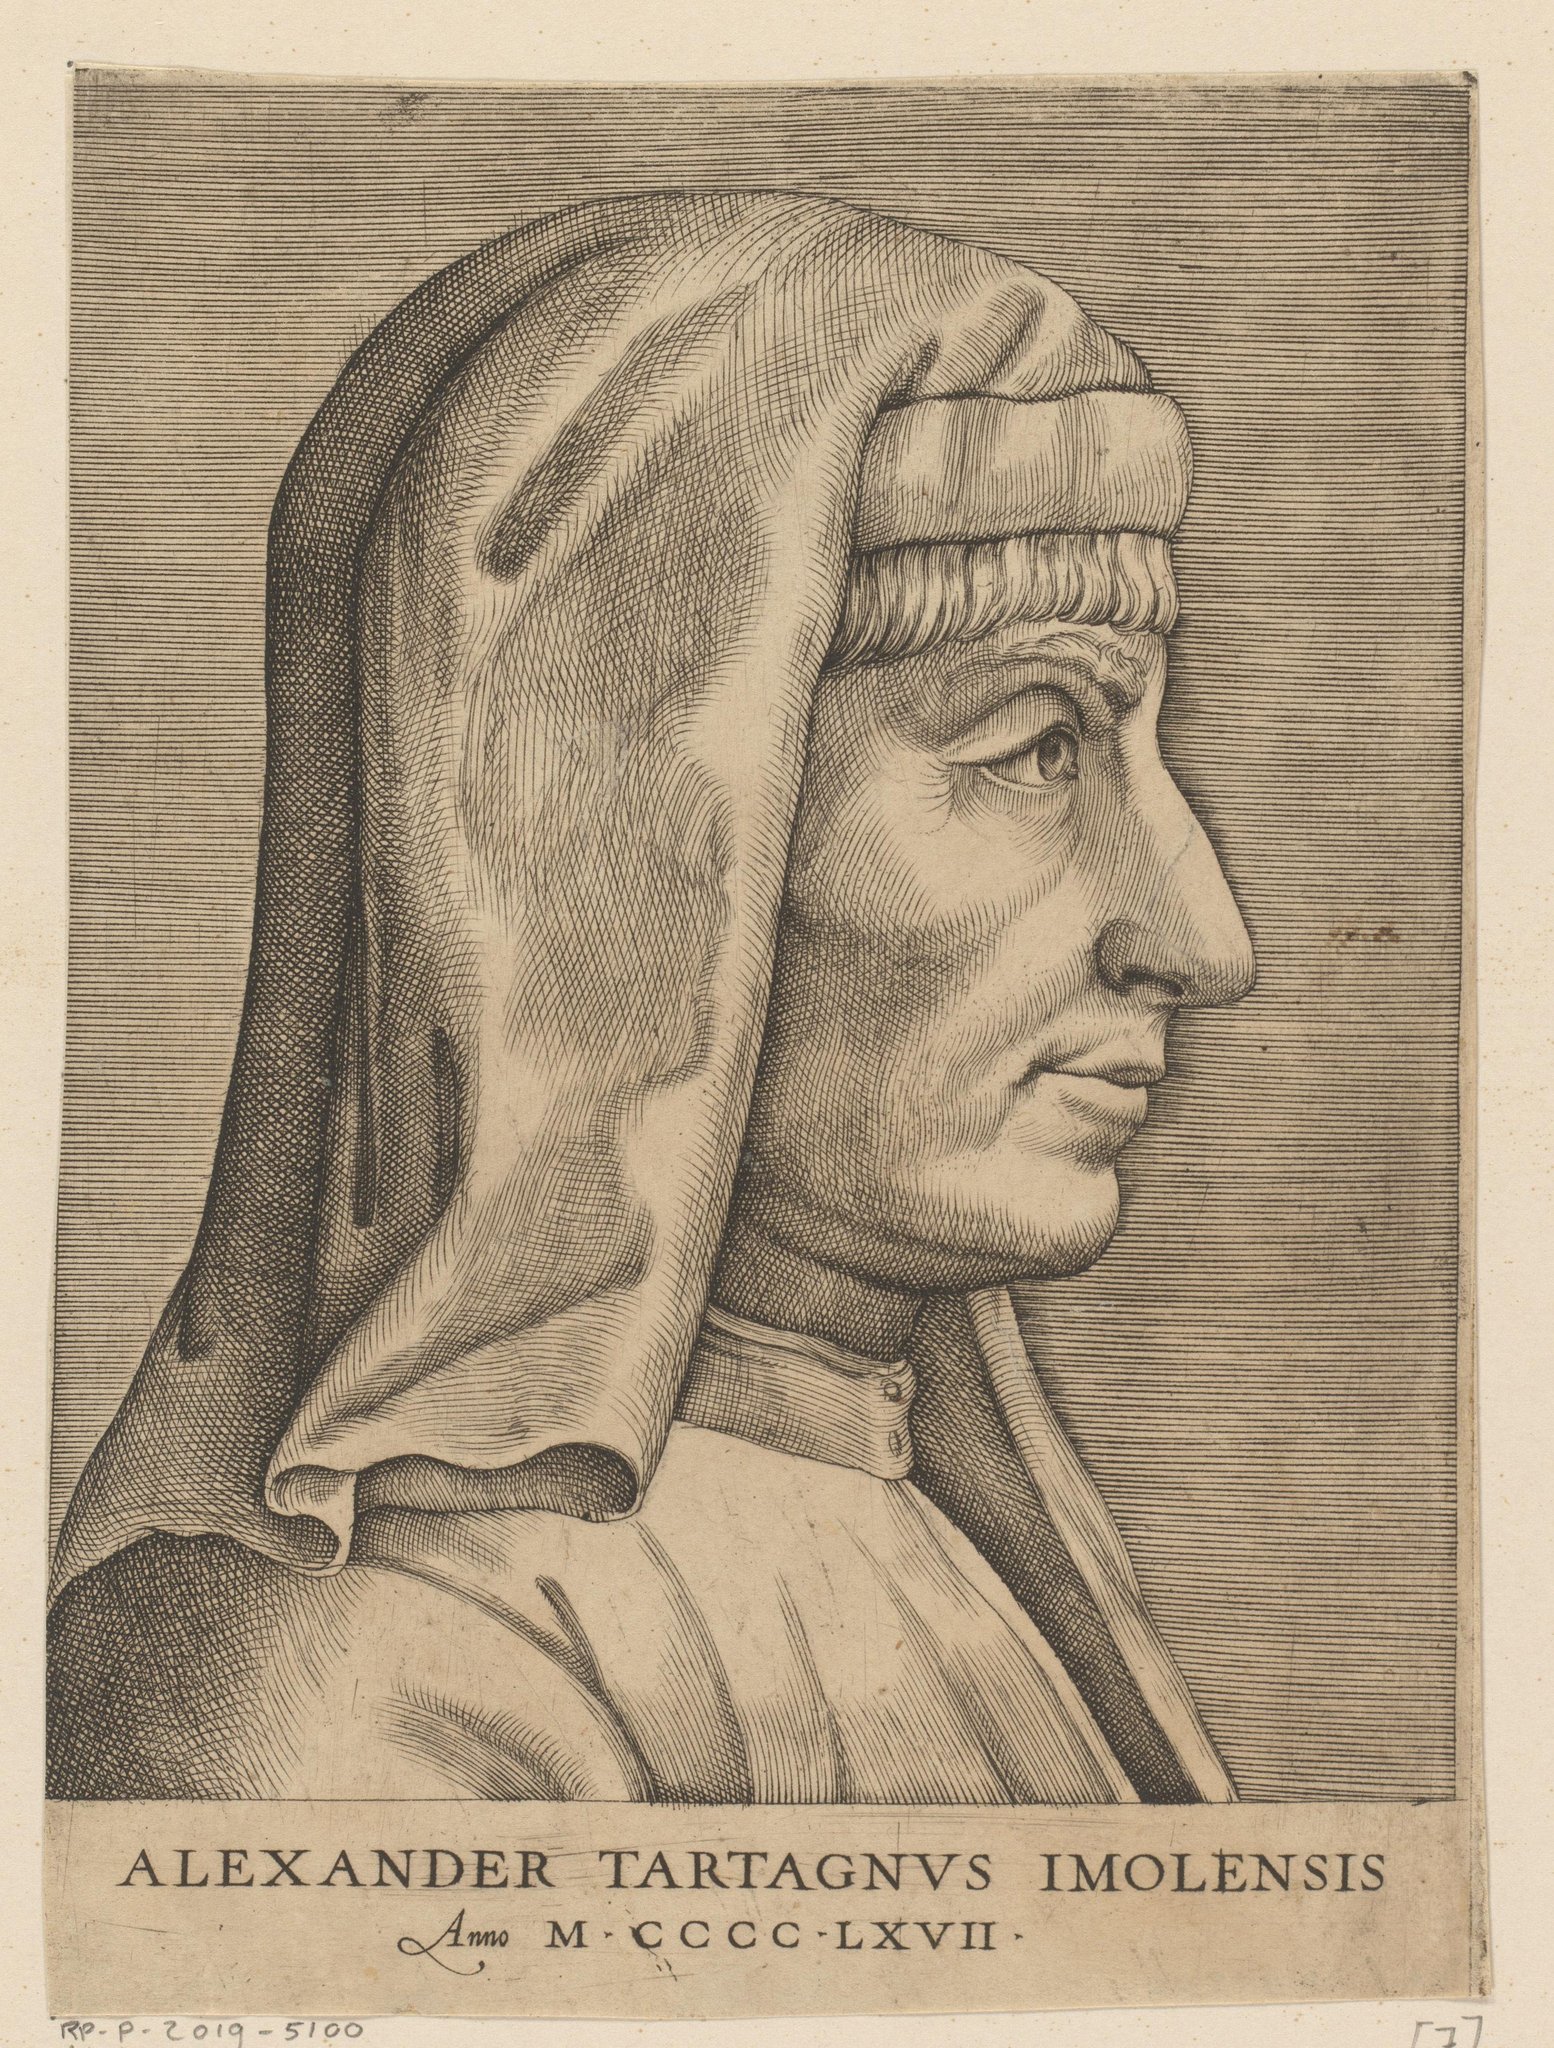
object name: print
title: Portret van Alessandro Tartagni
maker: Anonymous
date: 1566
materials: paper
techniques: engraving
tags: historical persons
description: Prentserie voor het eerst uitgegeven te Rome door Antonio Lafreri in 1566. Serie waarschijnlijk opnieuw uitgegeven door Petri de' Nobili rond 1584-1585.